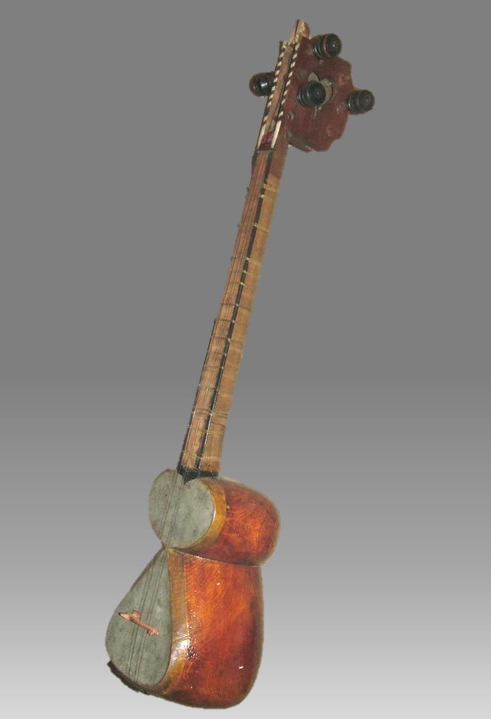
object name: tar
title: Tār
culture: azerbaijani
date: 1801-1900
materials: bone, metal, skin, wood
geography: georgia